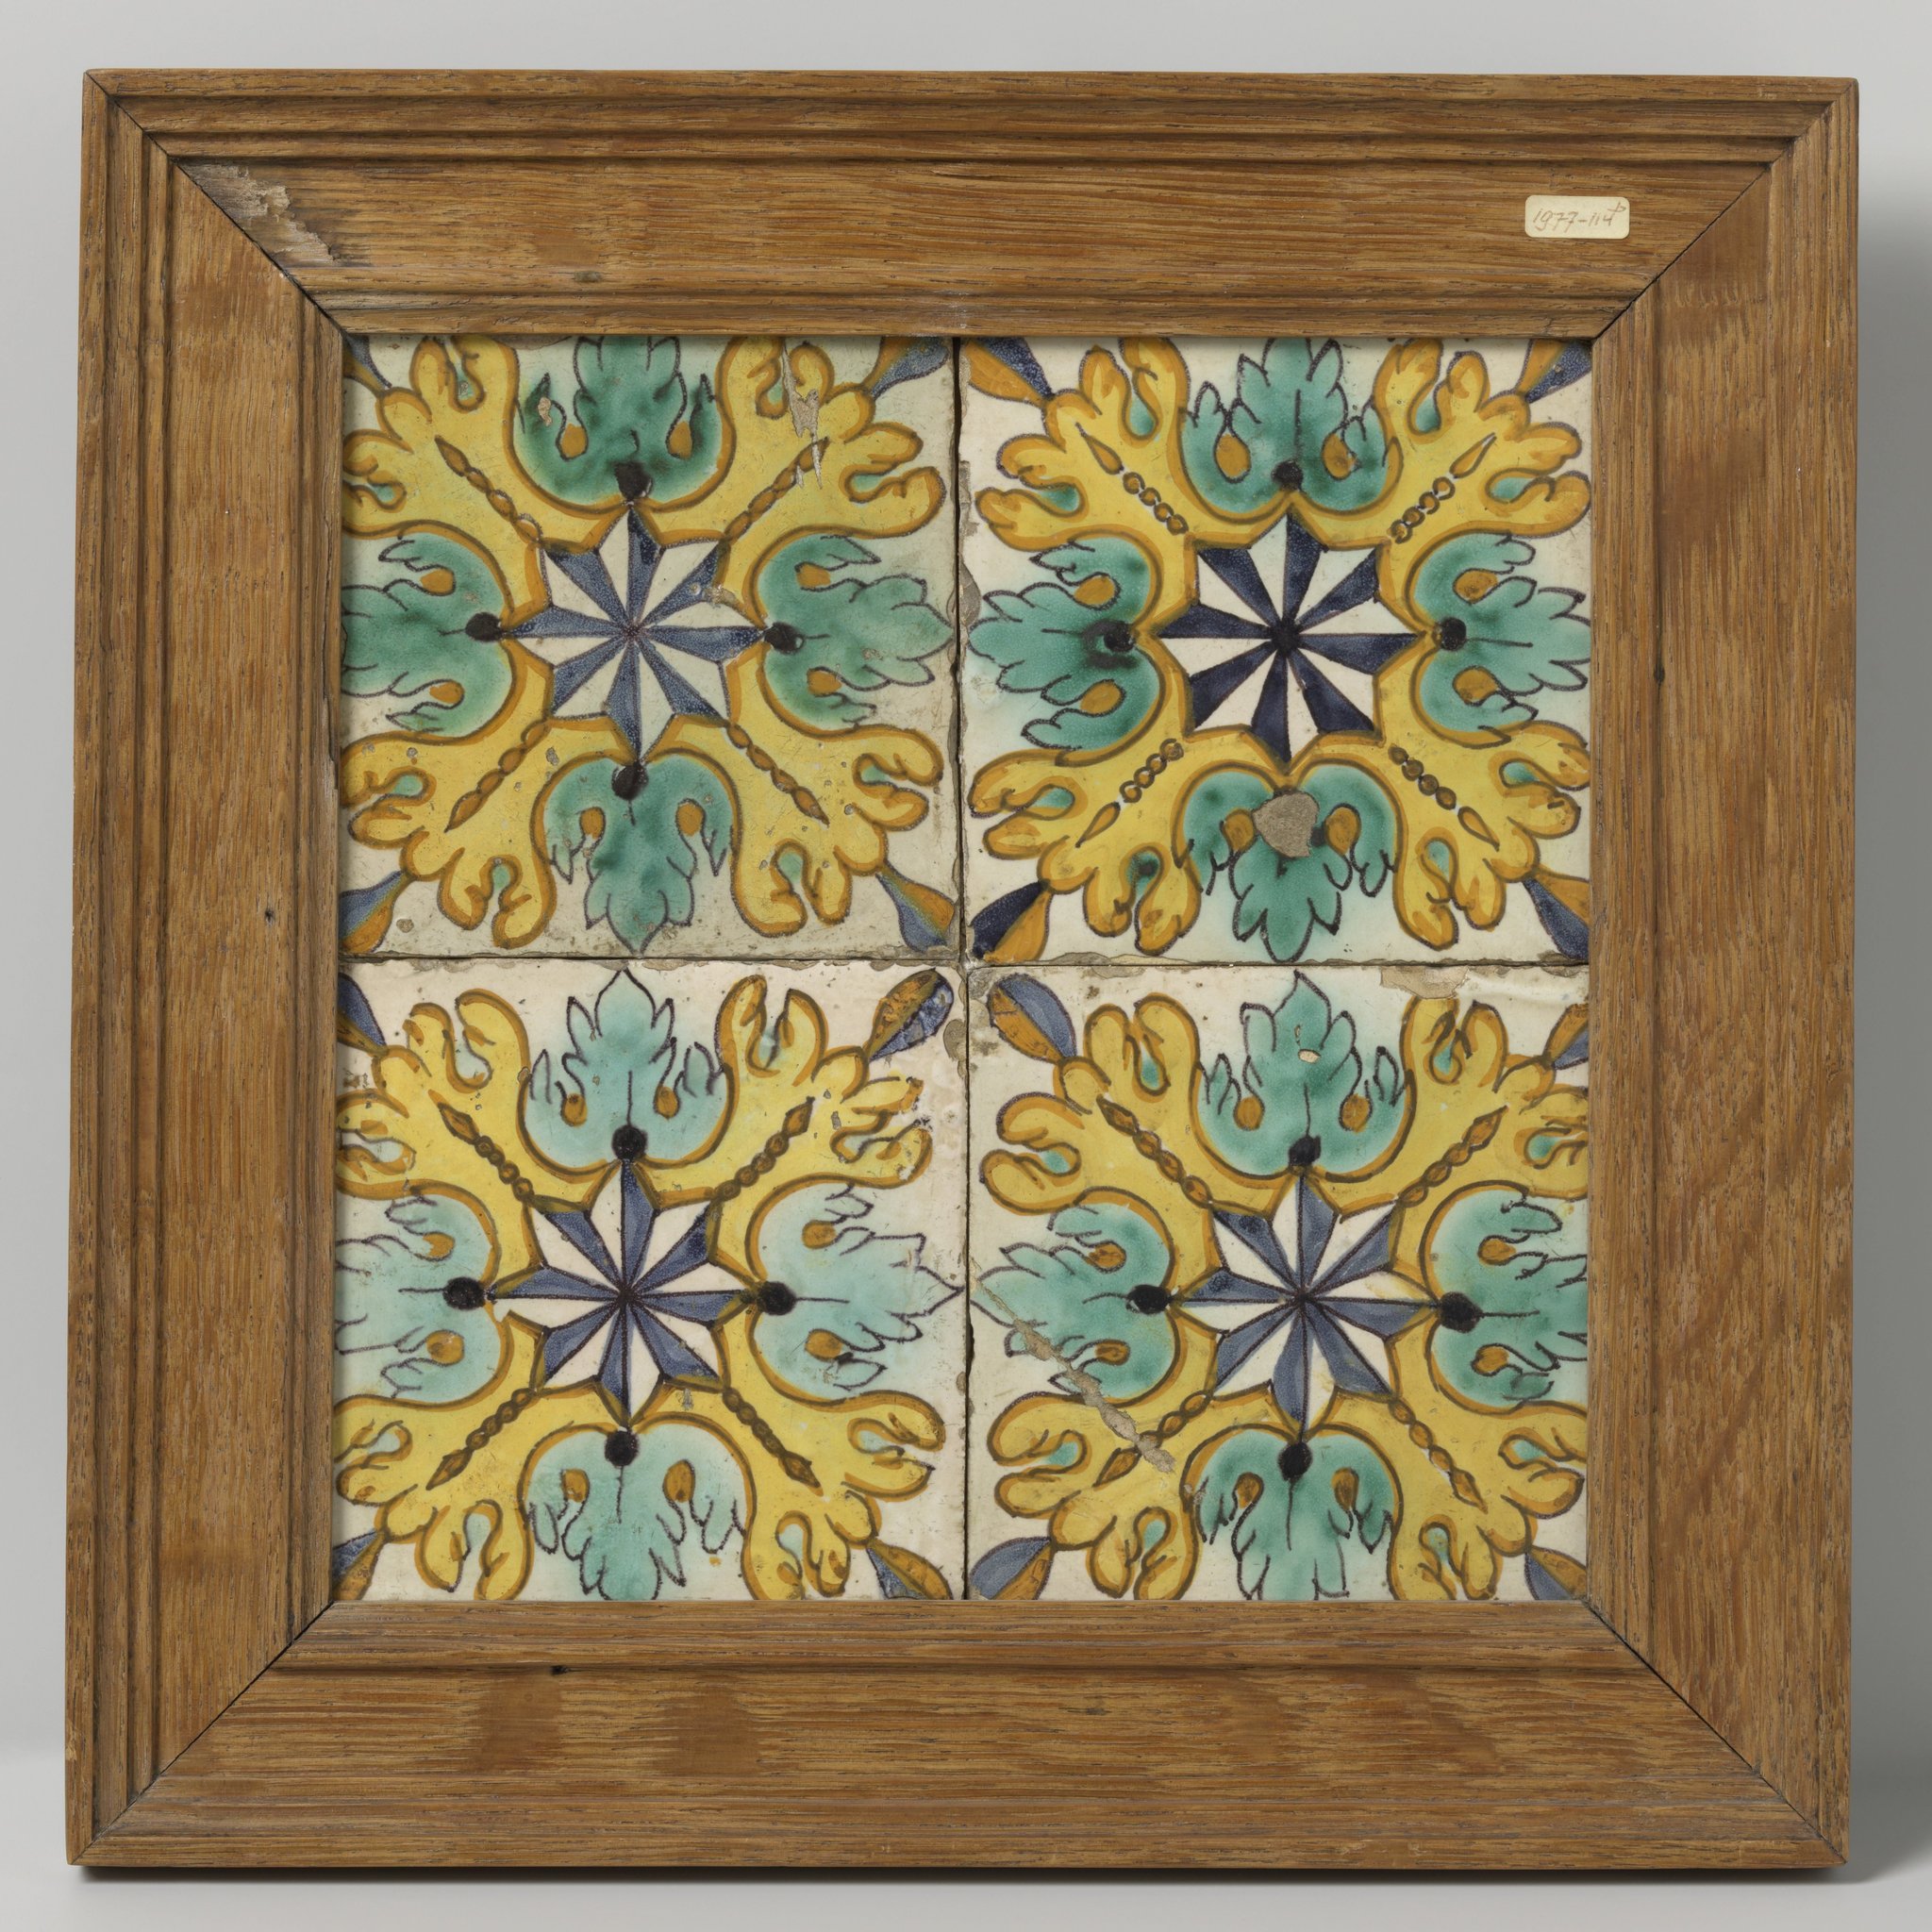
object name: tile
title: Tegel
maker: Anonymous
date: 1700-1800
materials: earthenware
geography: spain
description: Vier tegels van aardewerk, beschilderd in blauw, geel, groen, oranje en mangaan, bladrozet waarvan het centrum gevormd wordt door een achtpuntige ster in blauw en wit. (In moderne houten lijst).